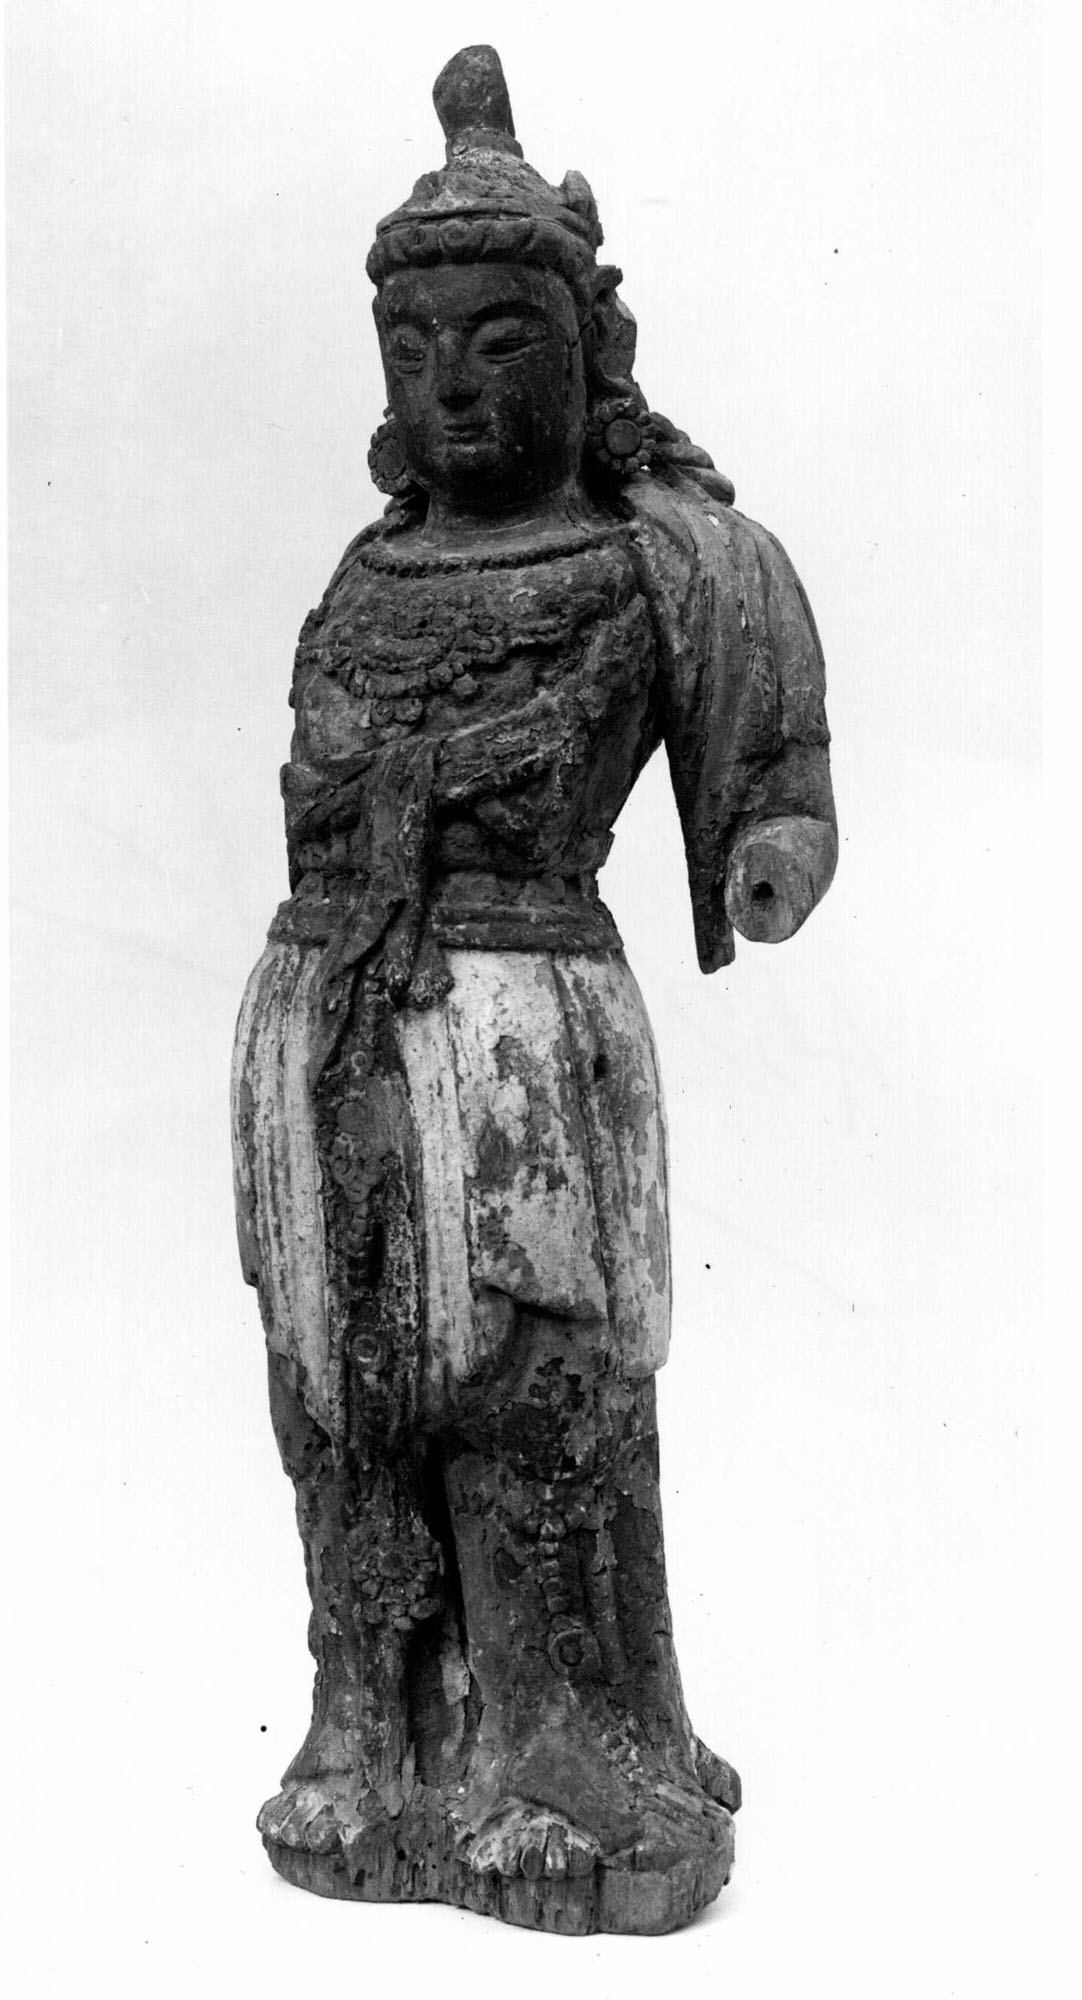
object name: statuette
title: Bodhisattva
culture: chinese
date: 901-1000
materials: wood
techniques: polychrome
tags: bodhisattvas